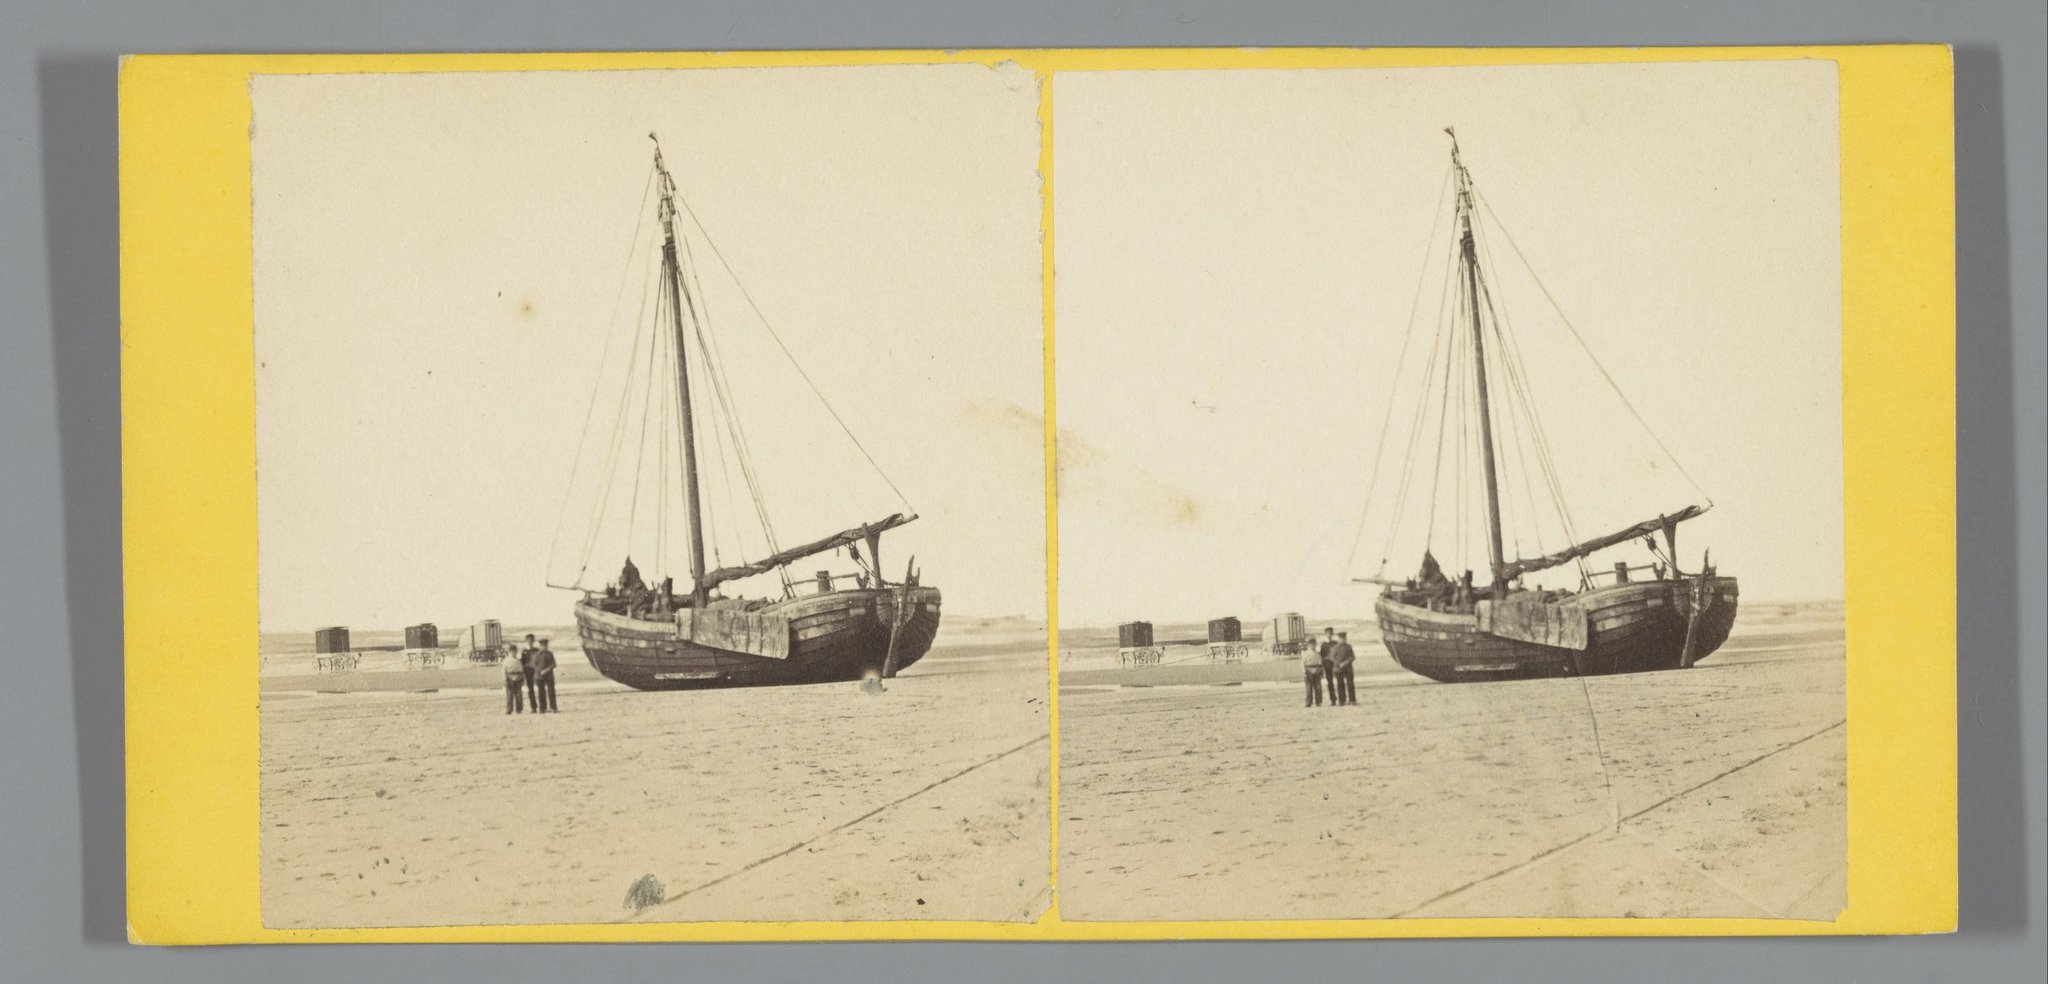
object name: stereograph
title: Gezicht op een schip op het strand van Scheveningen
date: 1860-1885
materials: cardboard, photographic support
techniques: albumen print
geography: amsterdam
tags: ships, boats on land, beached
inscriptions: annotation: ‘ook in album [...] la Hollande’, inscription: ‘STRANDGEZIGT/ TE/ Scheveningen./ A. JAGER, WATER 110, TE AMSTERDAM.’